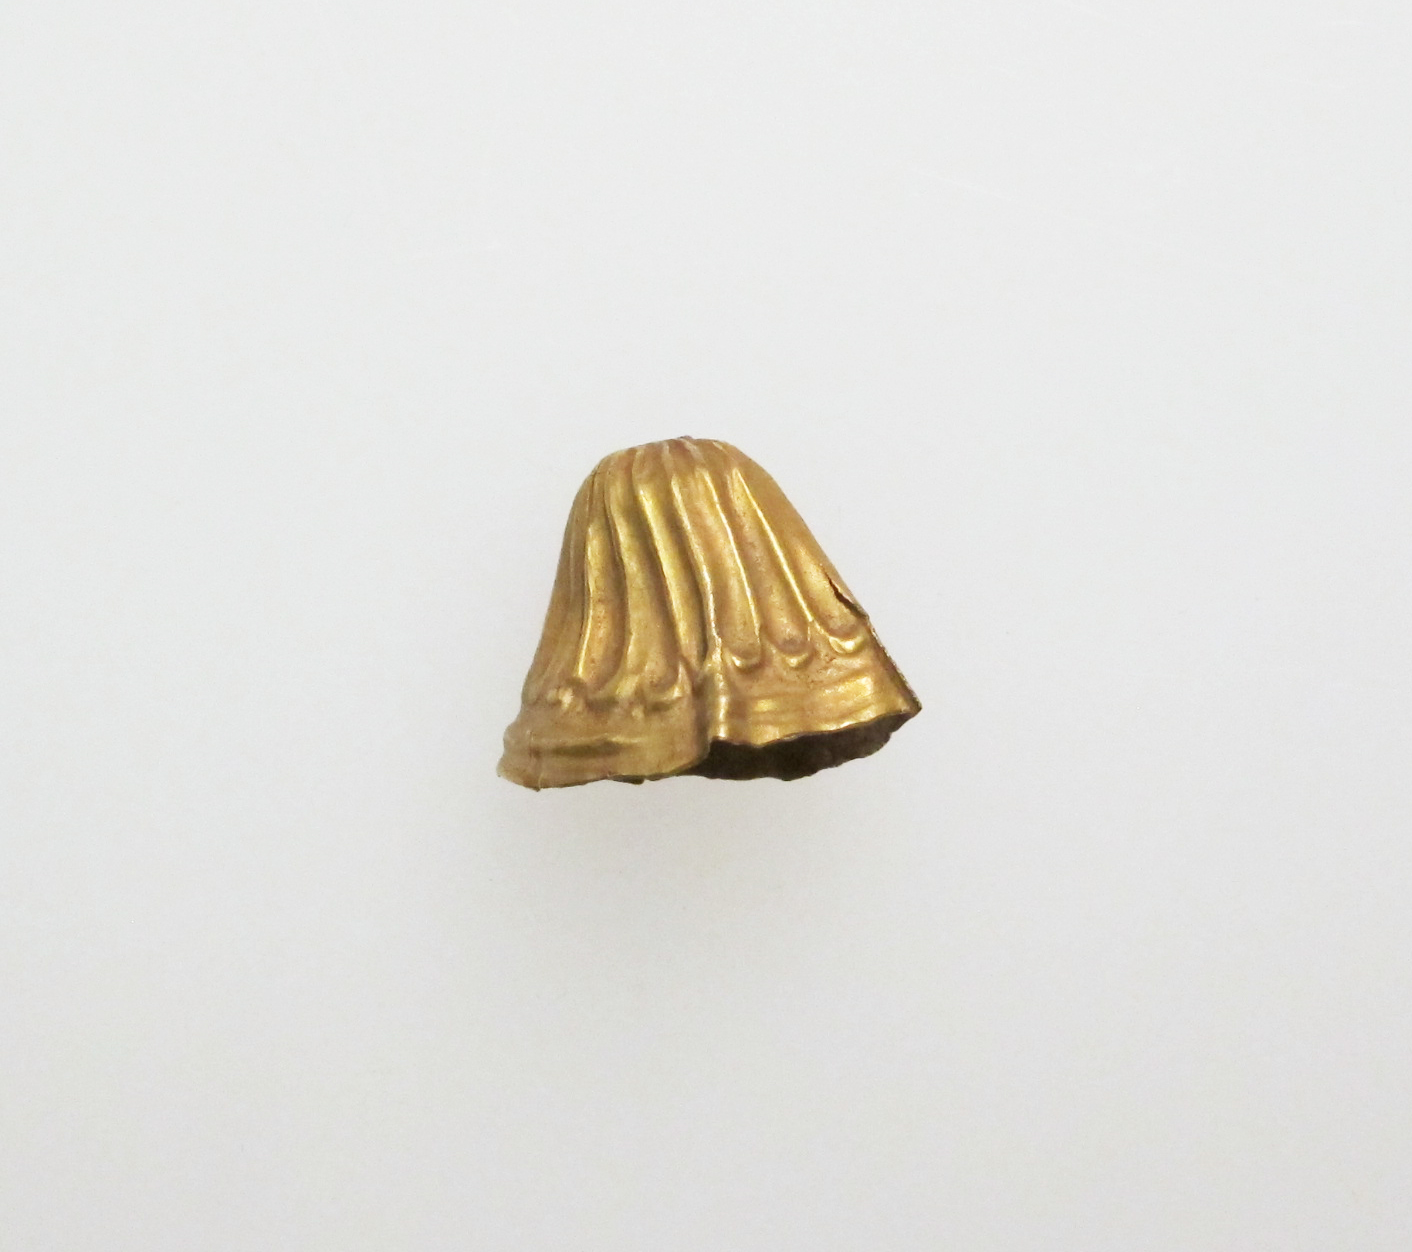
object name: bead ornament, bell shaped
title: Bead ornament, bell-shaped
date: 7000 BCE-330 CE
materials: gold